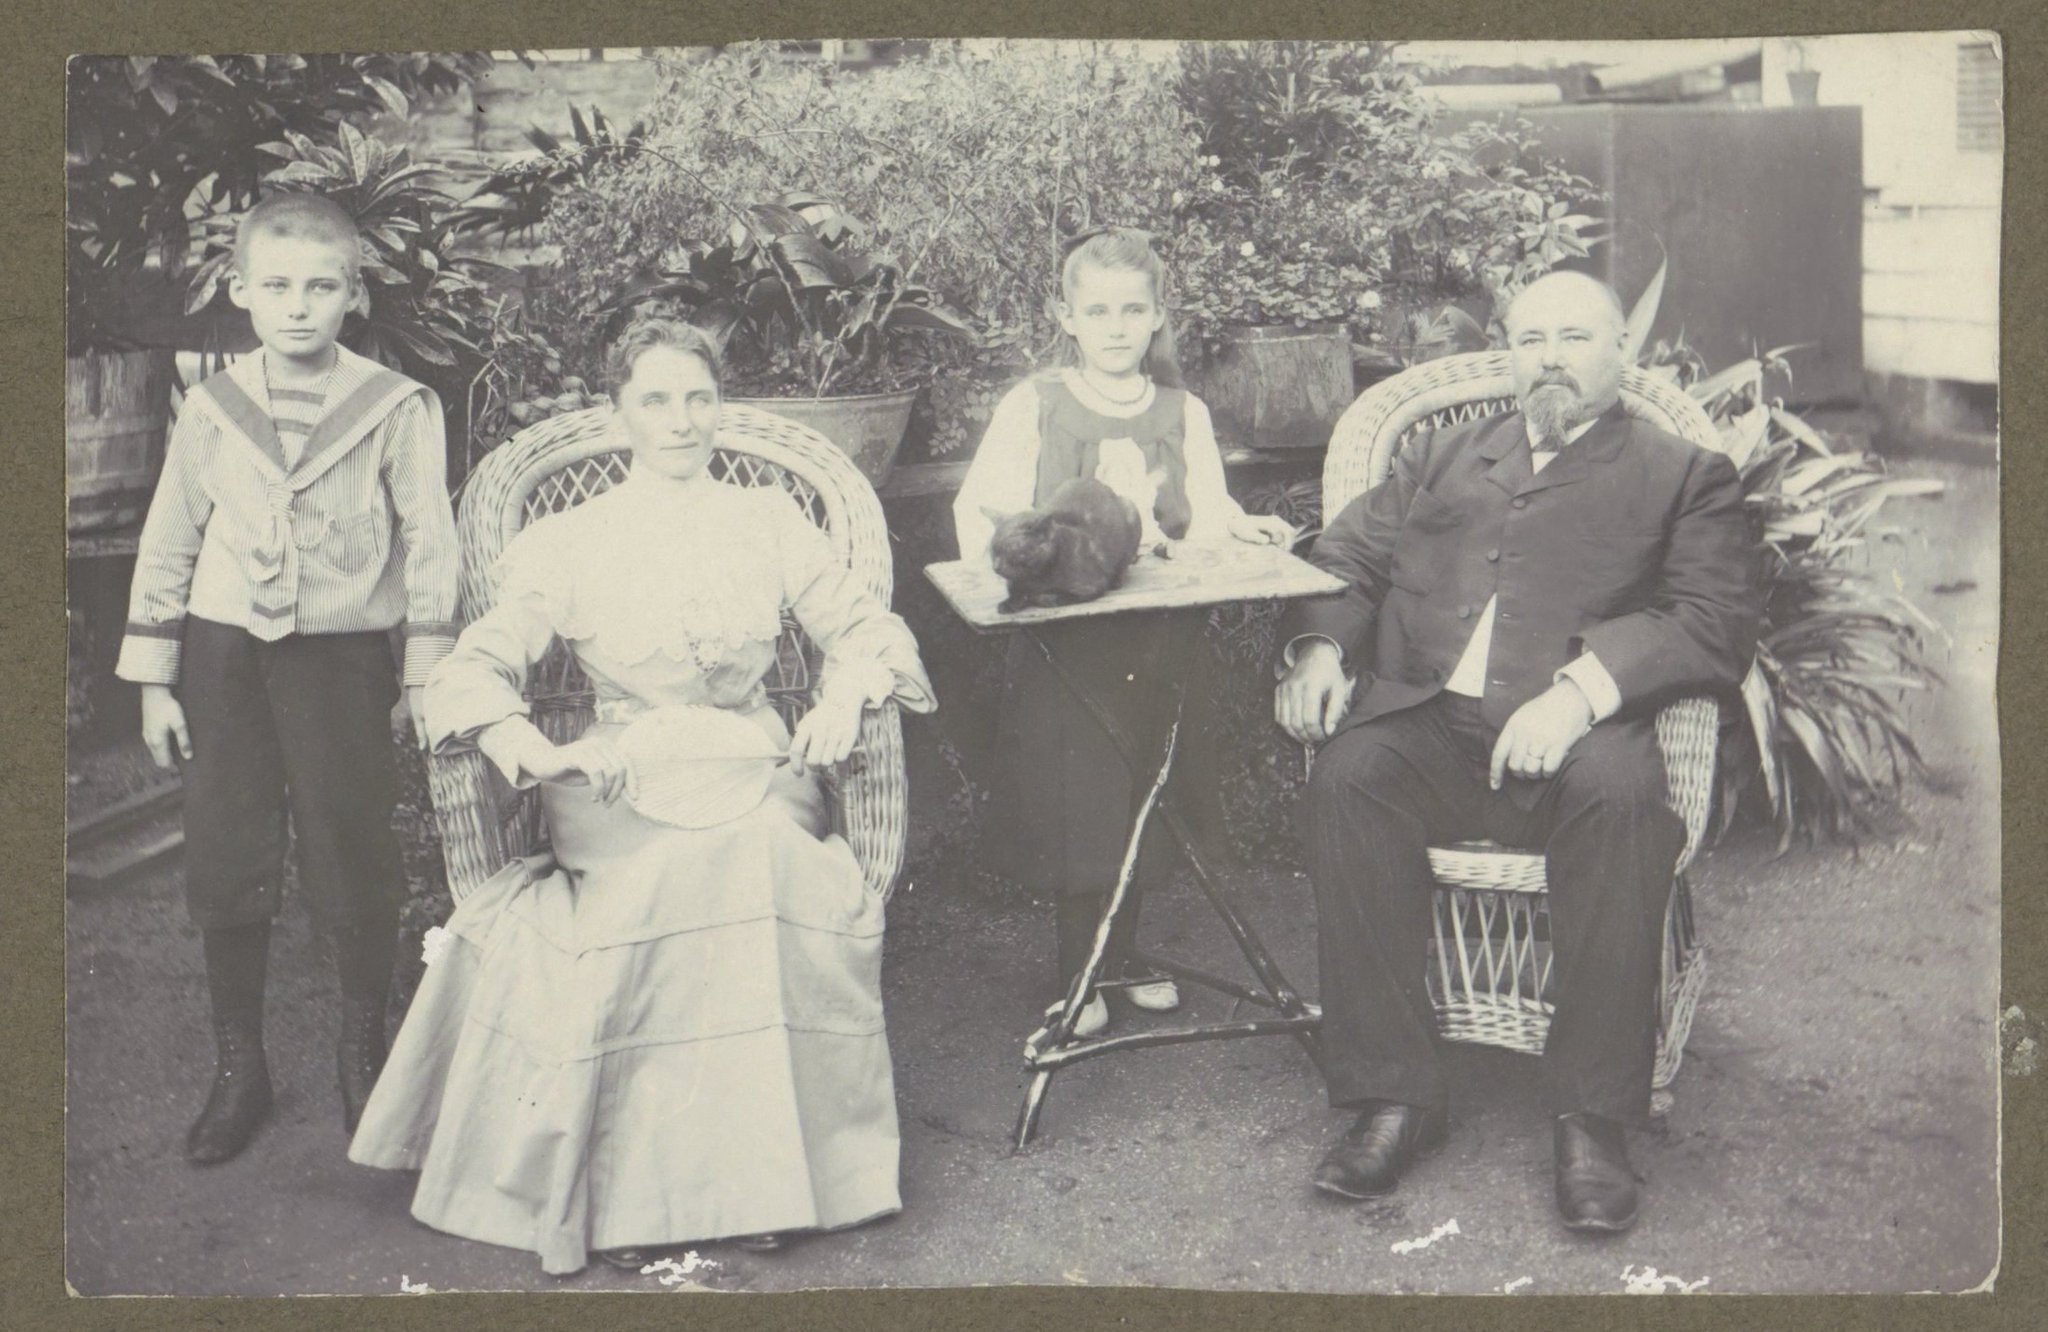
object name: photograph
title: Familieportret van man, vrouw, kinderen met kat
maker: Anonymous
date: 1920-1930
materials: photographic support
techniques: daylight paper print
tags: family group, especially parents with their child(ren)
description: Onderdeel van fotoalbum van een onbekende Nederlandse familie met opnames van Suriname, Europa en Nederlands-Indië.